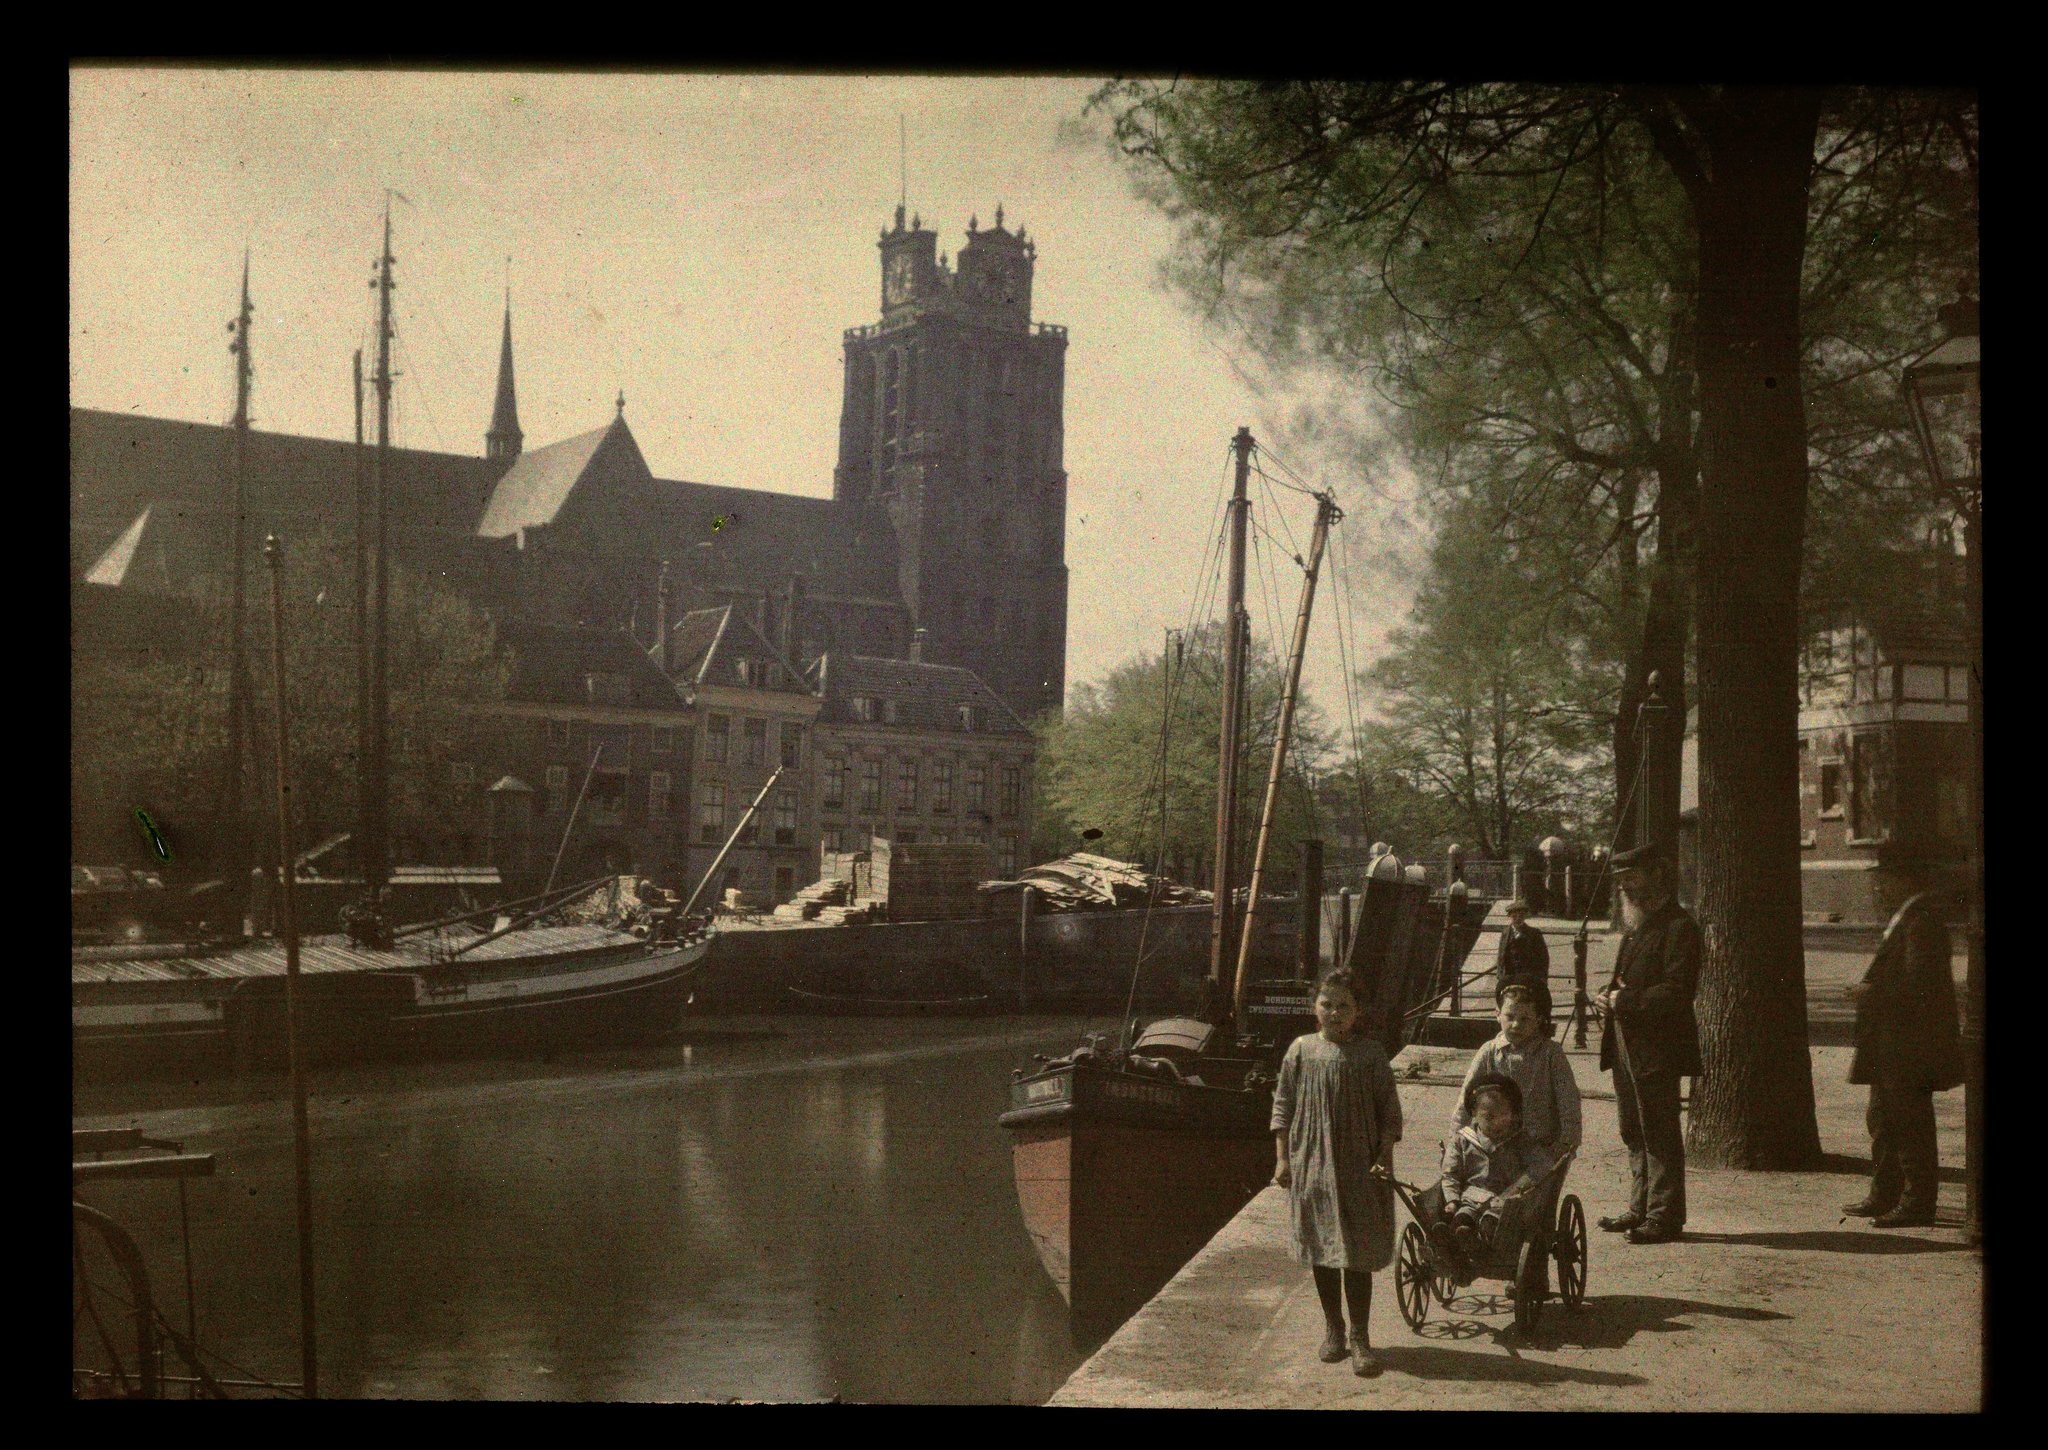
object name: photograph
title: De Grote Kerk te Dordrecht, gezien vanaf de Nieuwe Haven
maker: sebastiaan alphonse van besten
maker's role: painter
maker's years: 1864-1926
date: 1916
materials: glass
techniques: autochrome process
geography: dordrecht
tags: church (exterior)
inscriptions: annotation: ‘Dordrecht 1916 / S.A. V. BESTEN’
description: De Grote Kerk te Dordrecht, gezien vanaf de Nieuwe Haven. Op de kade drie kinderen van de familie den Duijtsen. In het water ligt het beurtvaartschip, de 'Industrie', van A & J den Duijtsen Goederenvervoer (dienst tussen Dordrecht en Rotterdam).